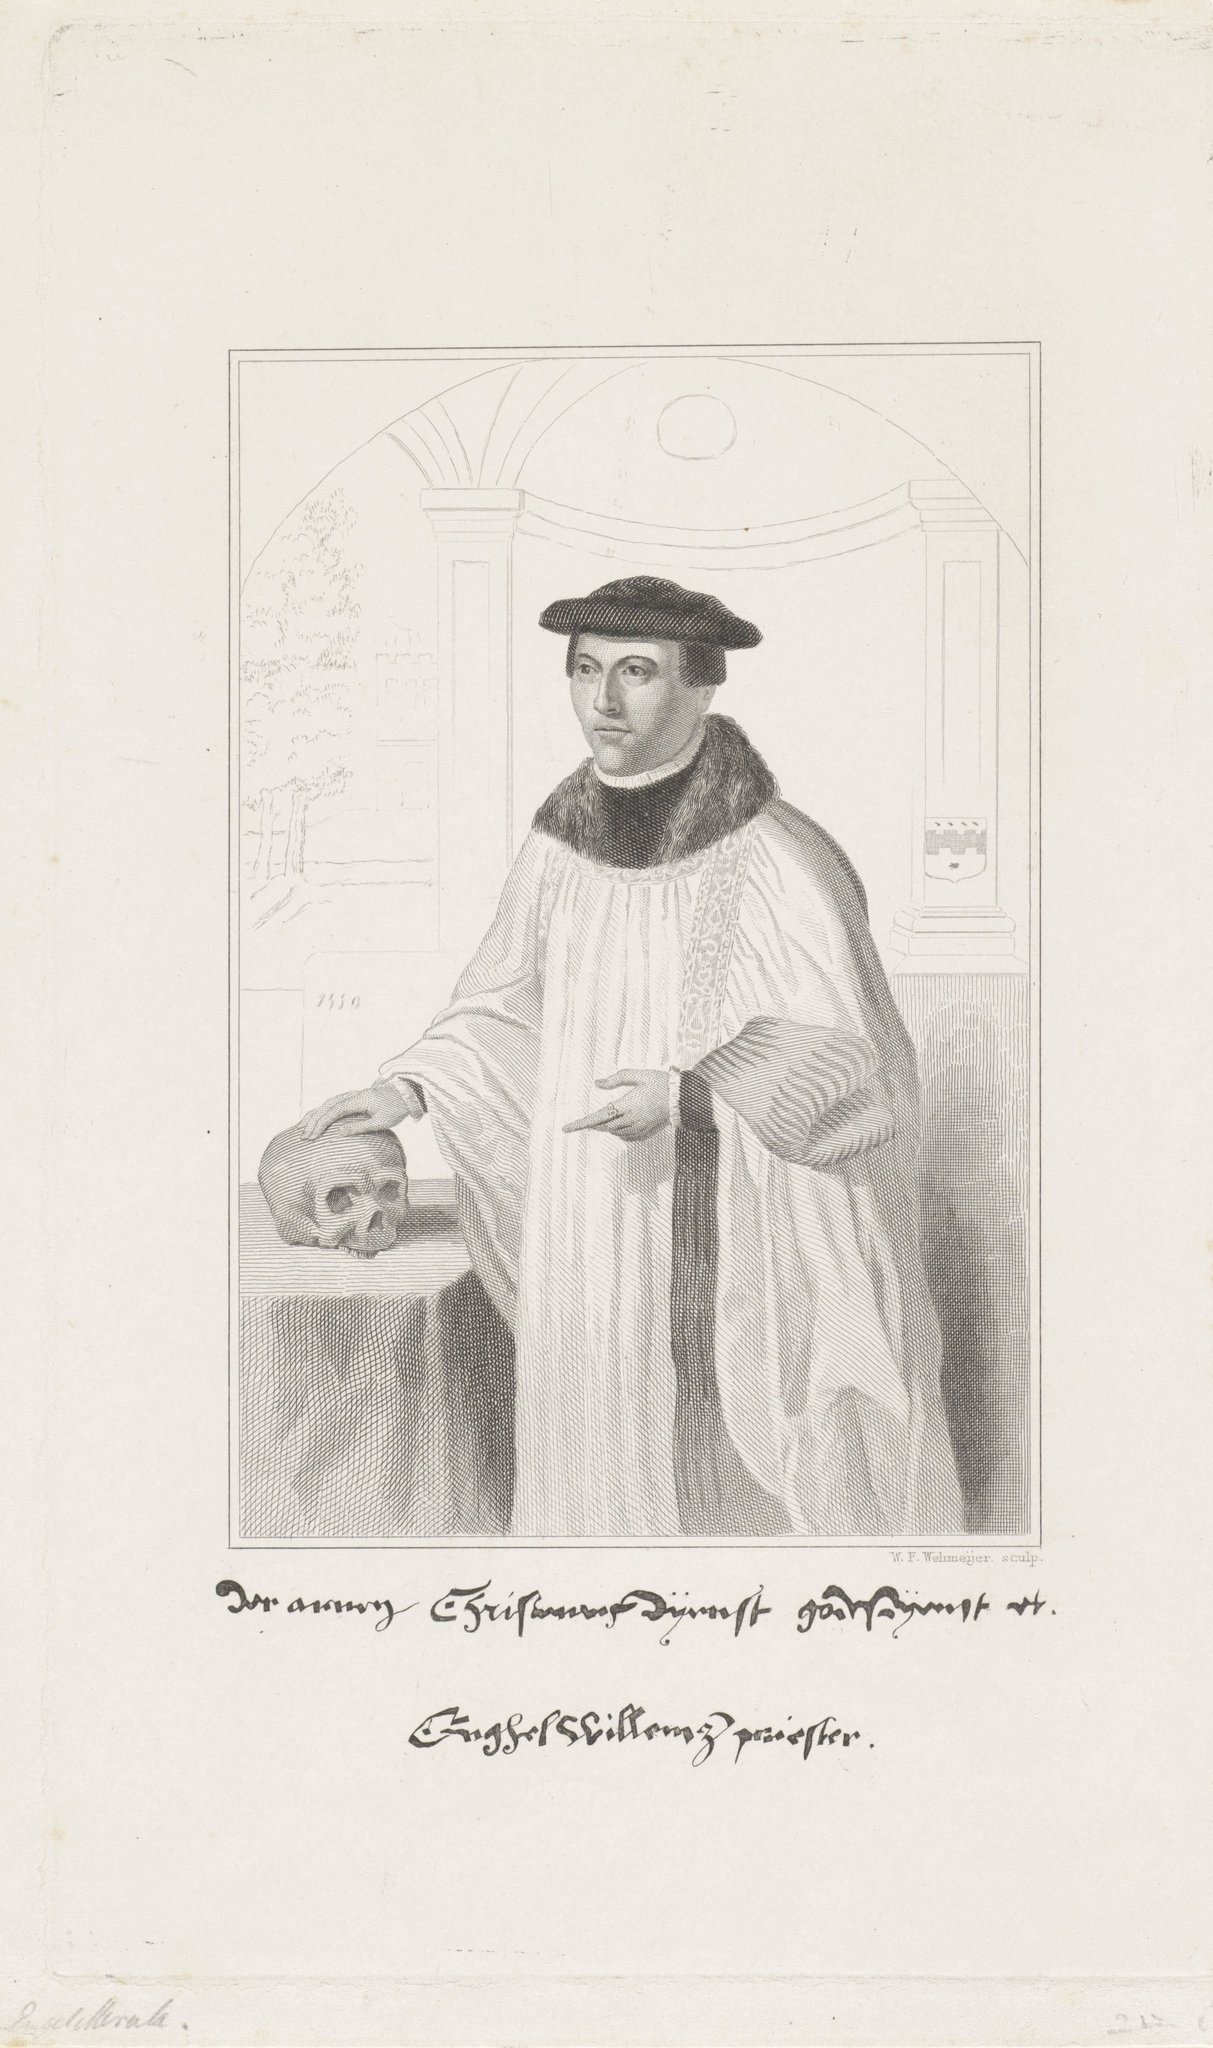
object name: print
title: Portret van Angelus Merula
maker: willem frederik wehmeyer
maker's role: print maker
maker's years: 1819-1854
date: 1834-1854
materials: paper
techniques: etching, roulette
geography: amsterdam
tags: brielle, bergen op zoom, adult man, historical persons, death's head, skull (symbol of death)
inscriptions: collector's mark: Lugt 2228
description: Portret van Angelus Merula, priester. Hij draagt een kazuifel en een baret. Zijn rechterhand rust op een schedel. Achter hem is een absis te zien. Onder de voorstelling bevindt zich een tweeregelige tekst met onder meer de naam van de geportretteerde.